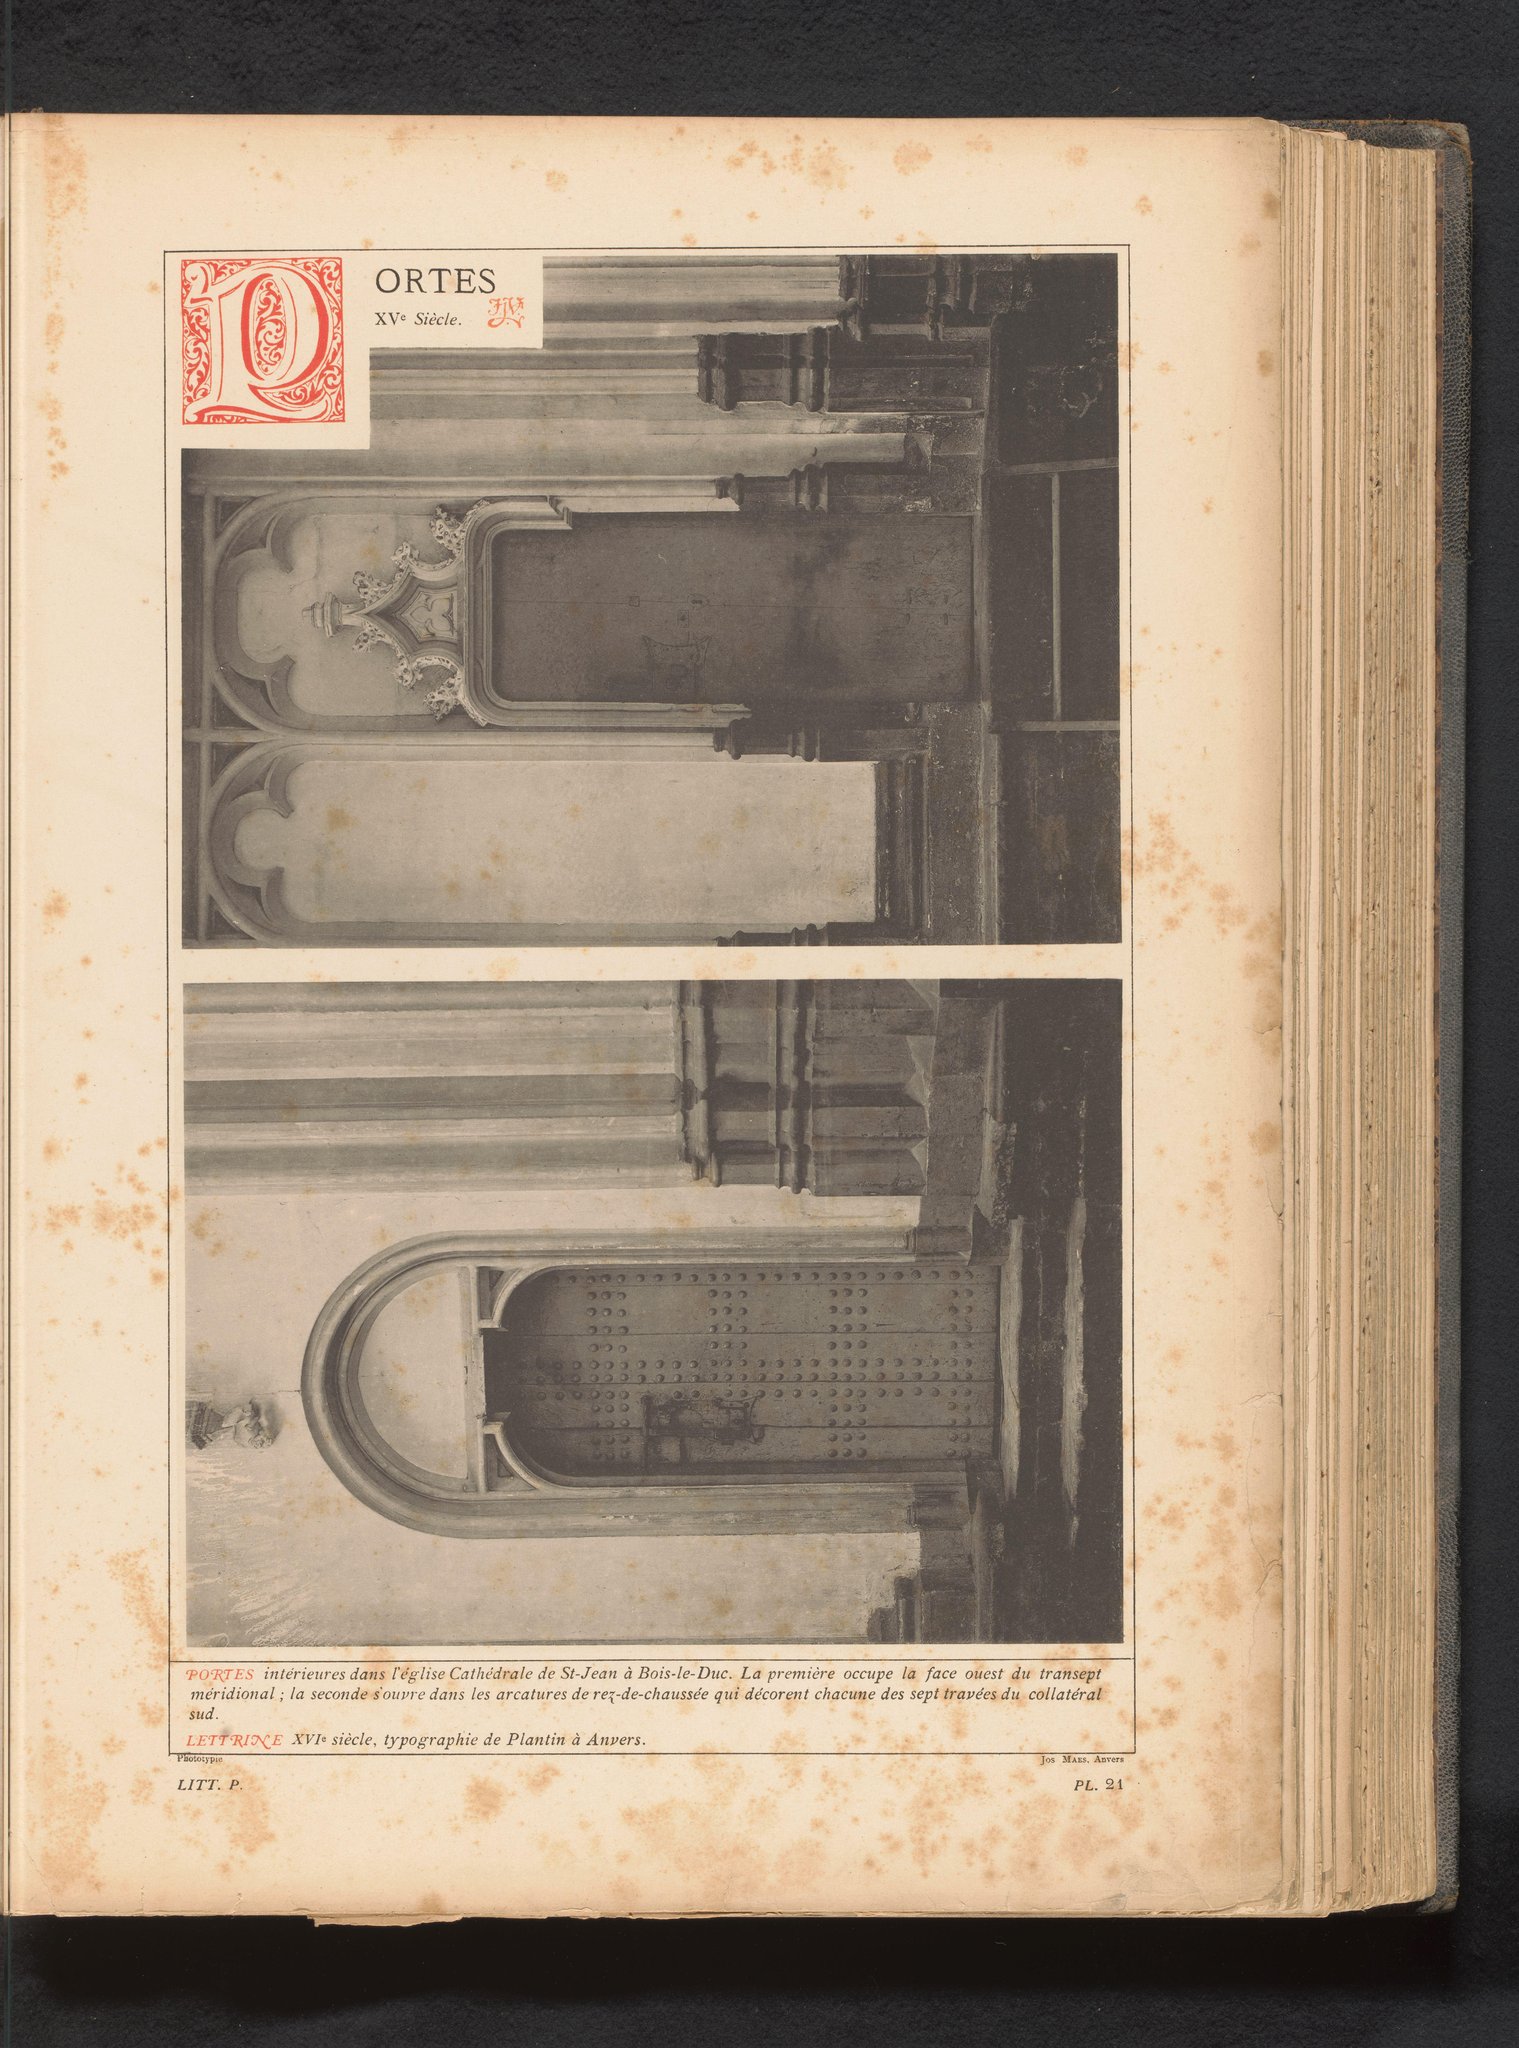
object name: page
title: Portes, XVe Siècle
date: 1876-1881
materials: paper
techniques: photograph, photolithography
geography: den bosch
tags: door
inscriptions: monogram: ‘JJvY’, inscription: ‘LITT. P. - PL. 21.’, inscription: ‘PORTES intérieures dans (...)’